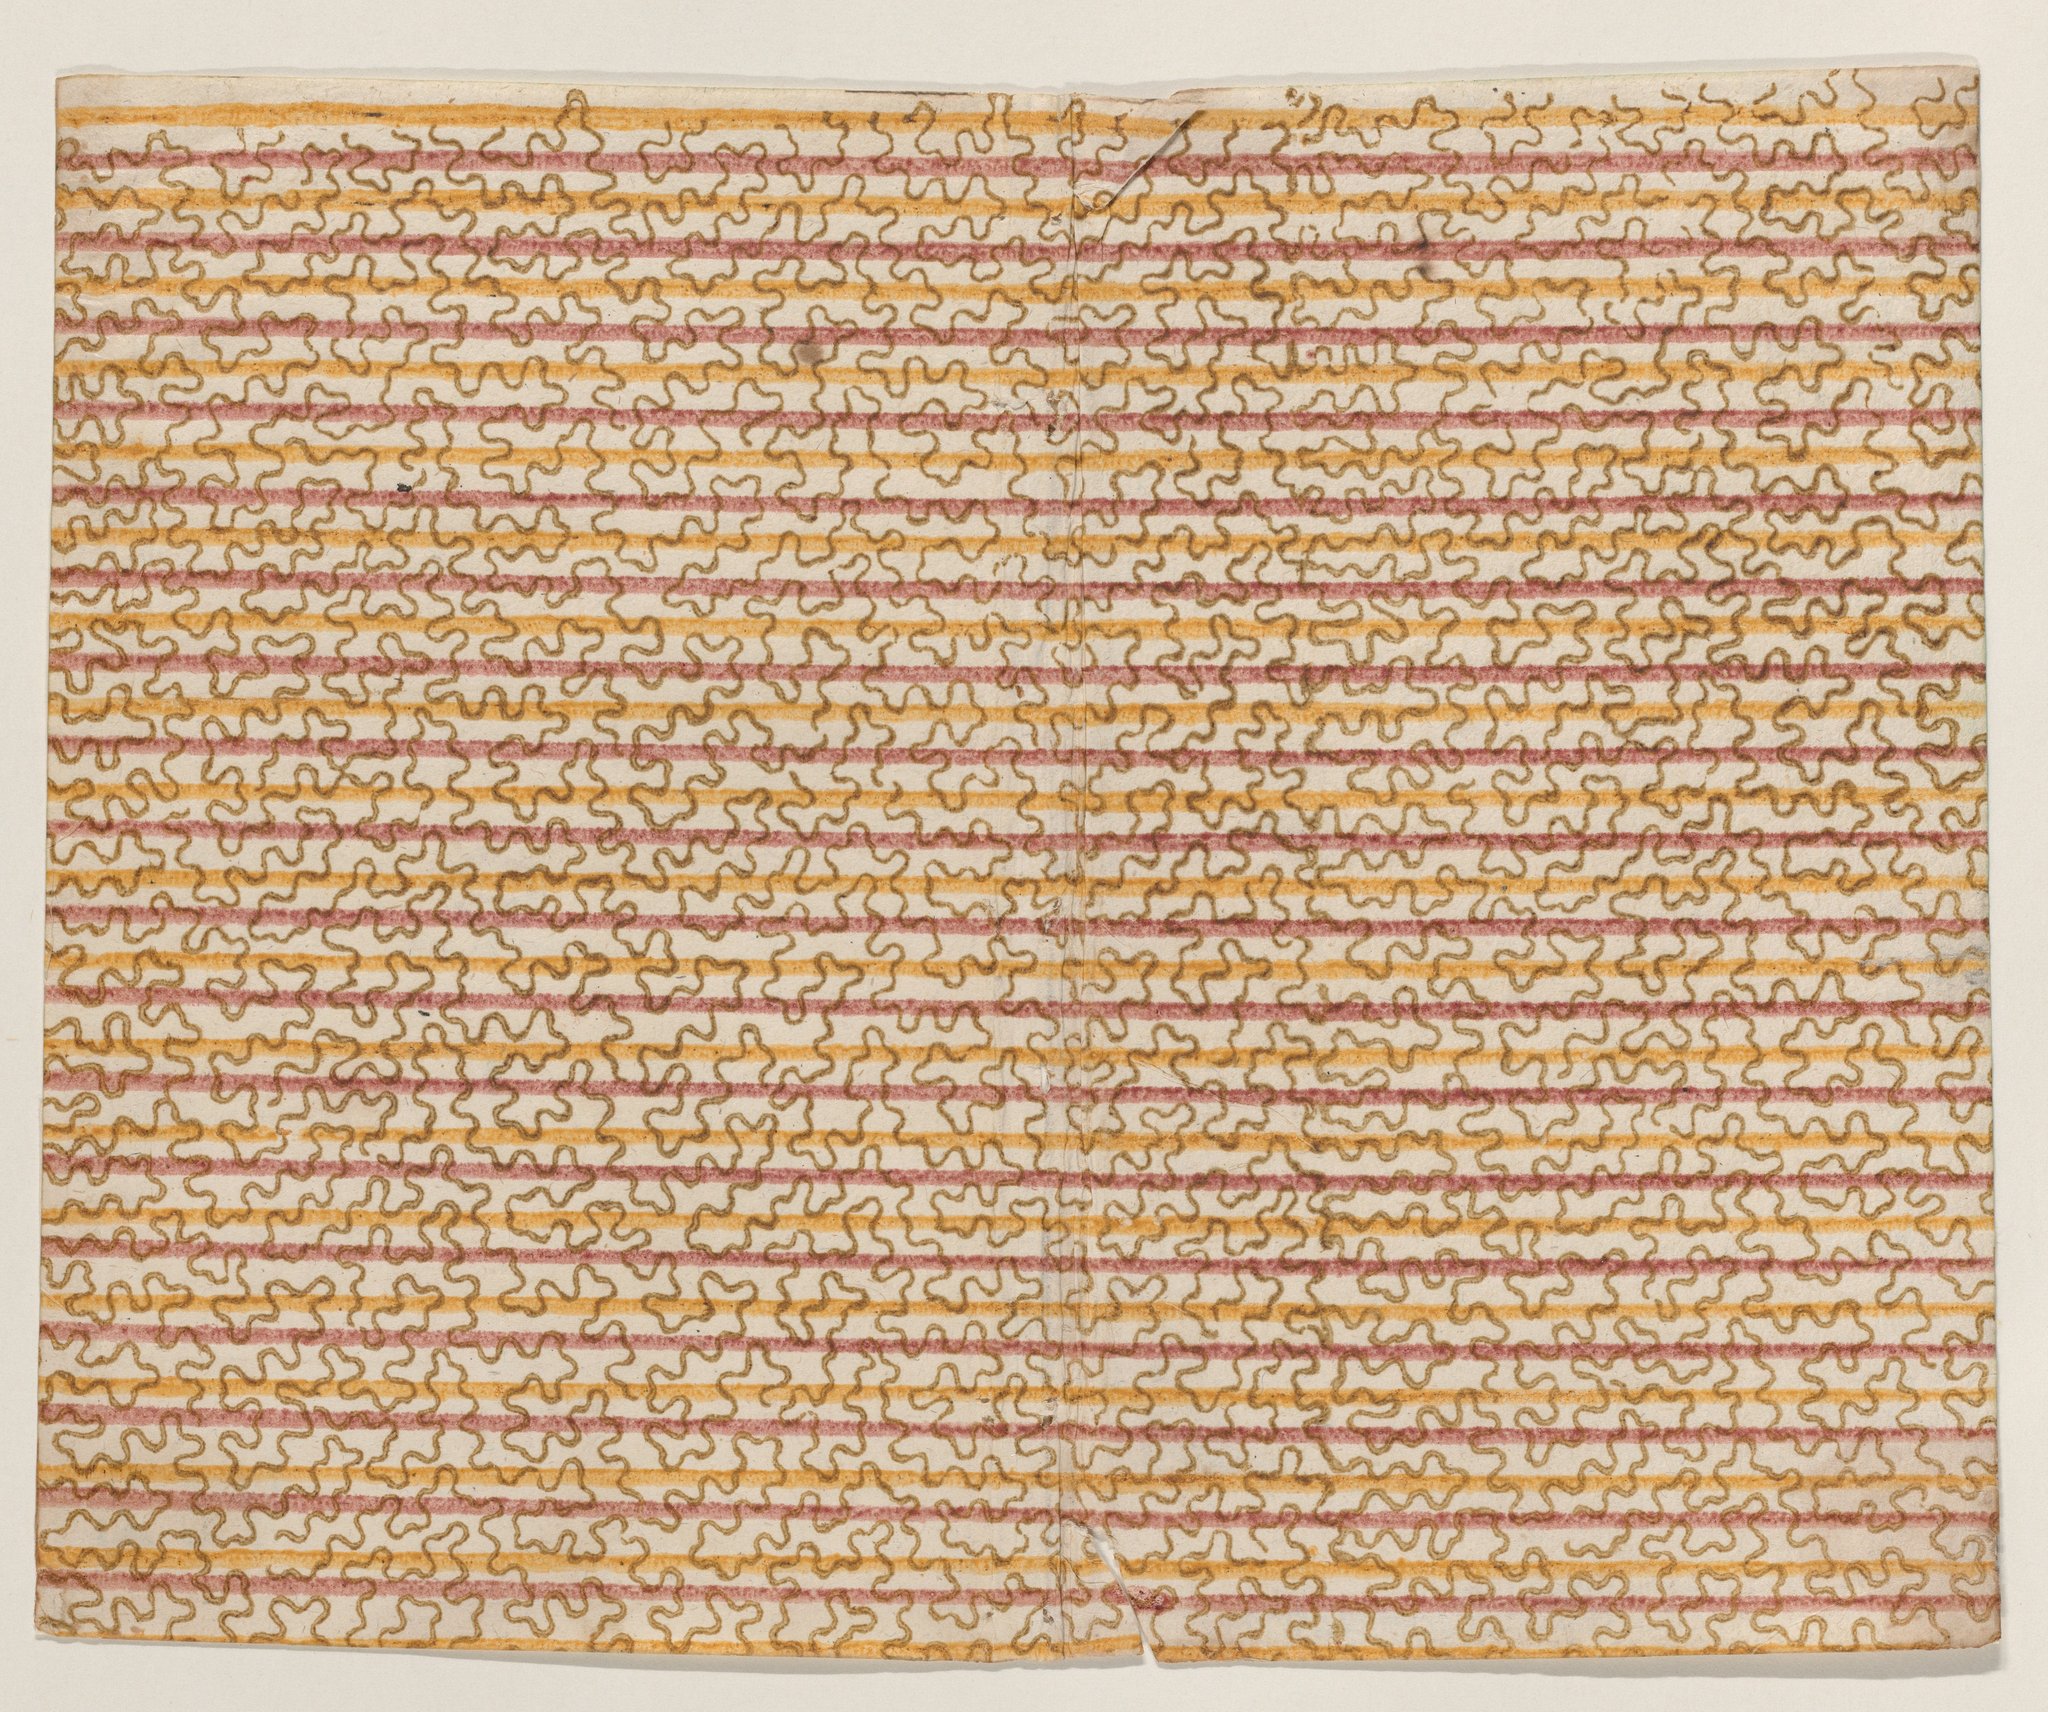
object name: print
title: Sheet with overall stripe pattern with squiggly lines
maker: Anonymous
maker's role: artist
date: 1801-1900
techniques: relief print